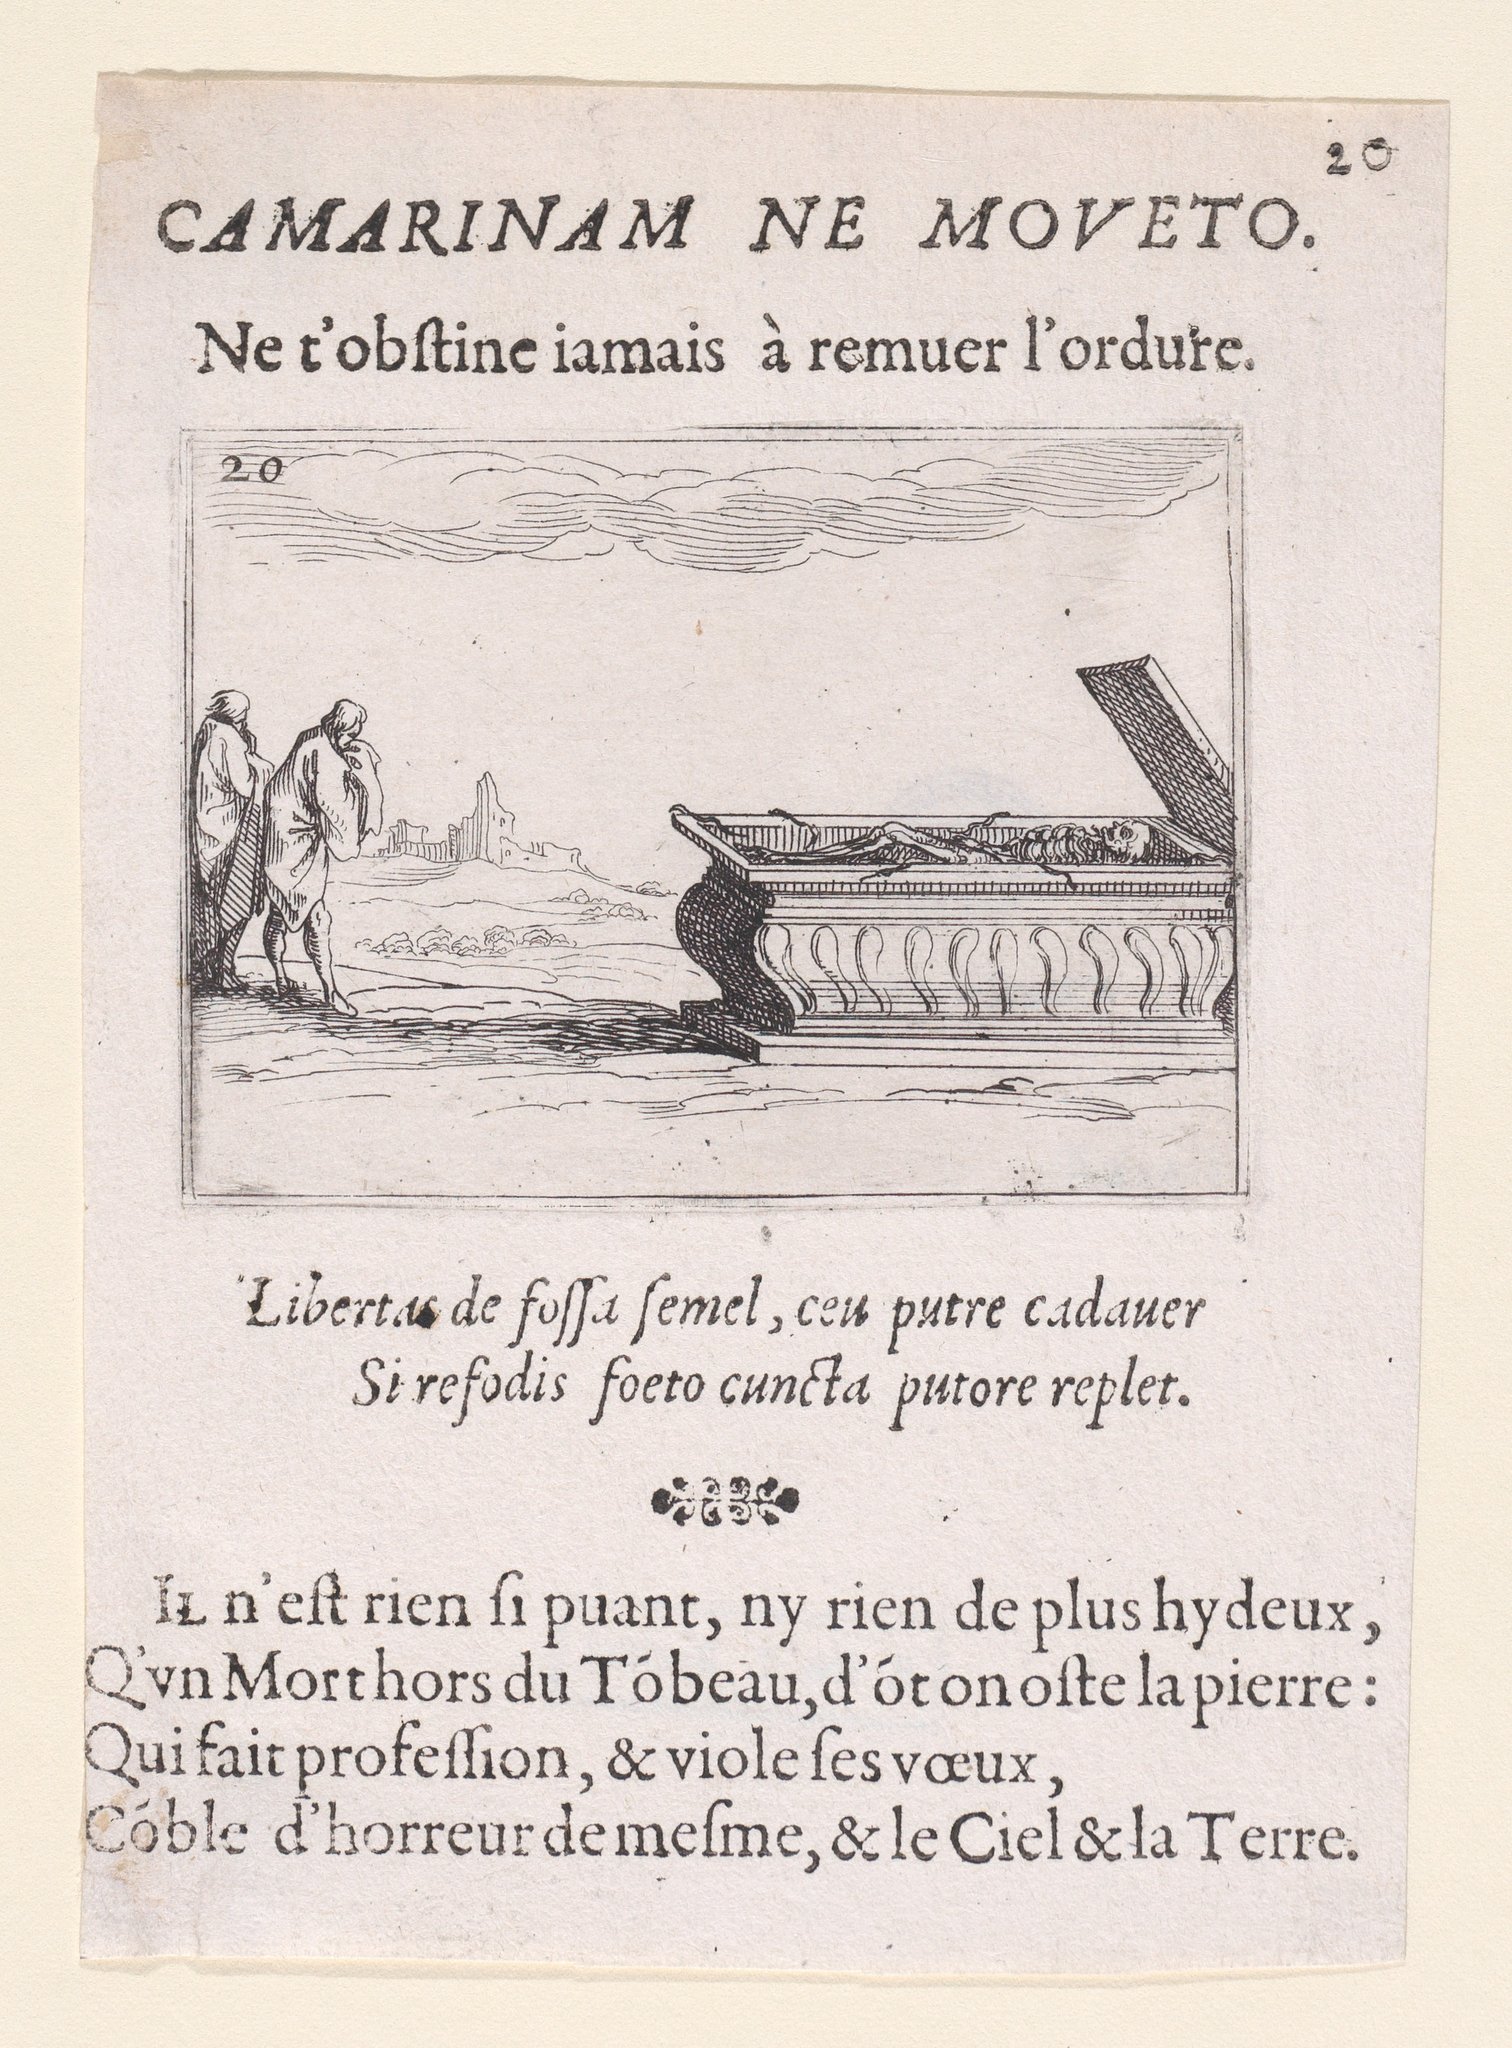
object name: print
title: Le Tombeau (The Tomb), plate 20 from "Lux Claustri ou La Lumière du Cloitre" (The Light of the Cloisters)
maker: jacques callot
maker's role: artist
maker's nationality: french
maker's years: 1592-1635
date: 1621-1635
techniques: etching, letterpress